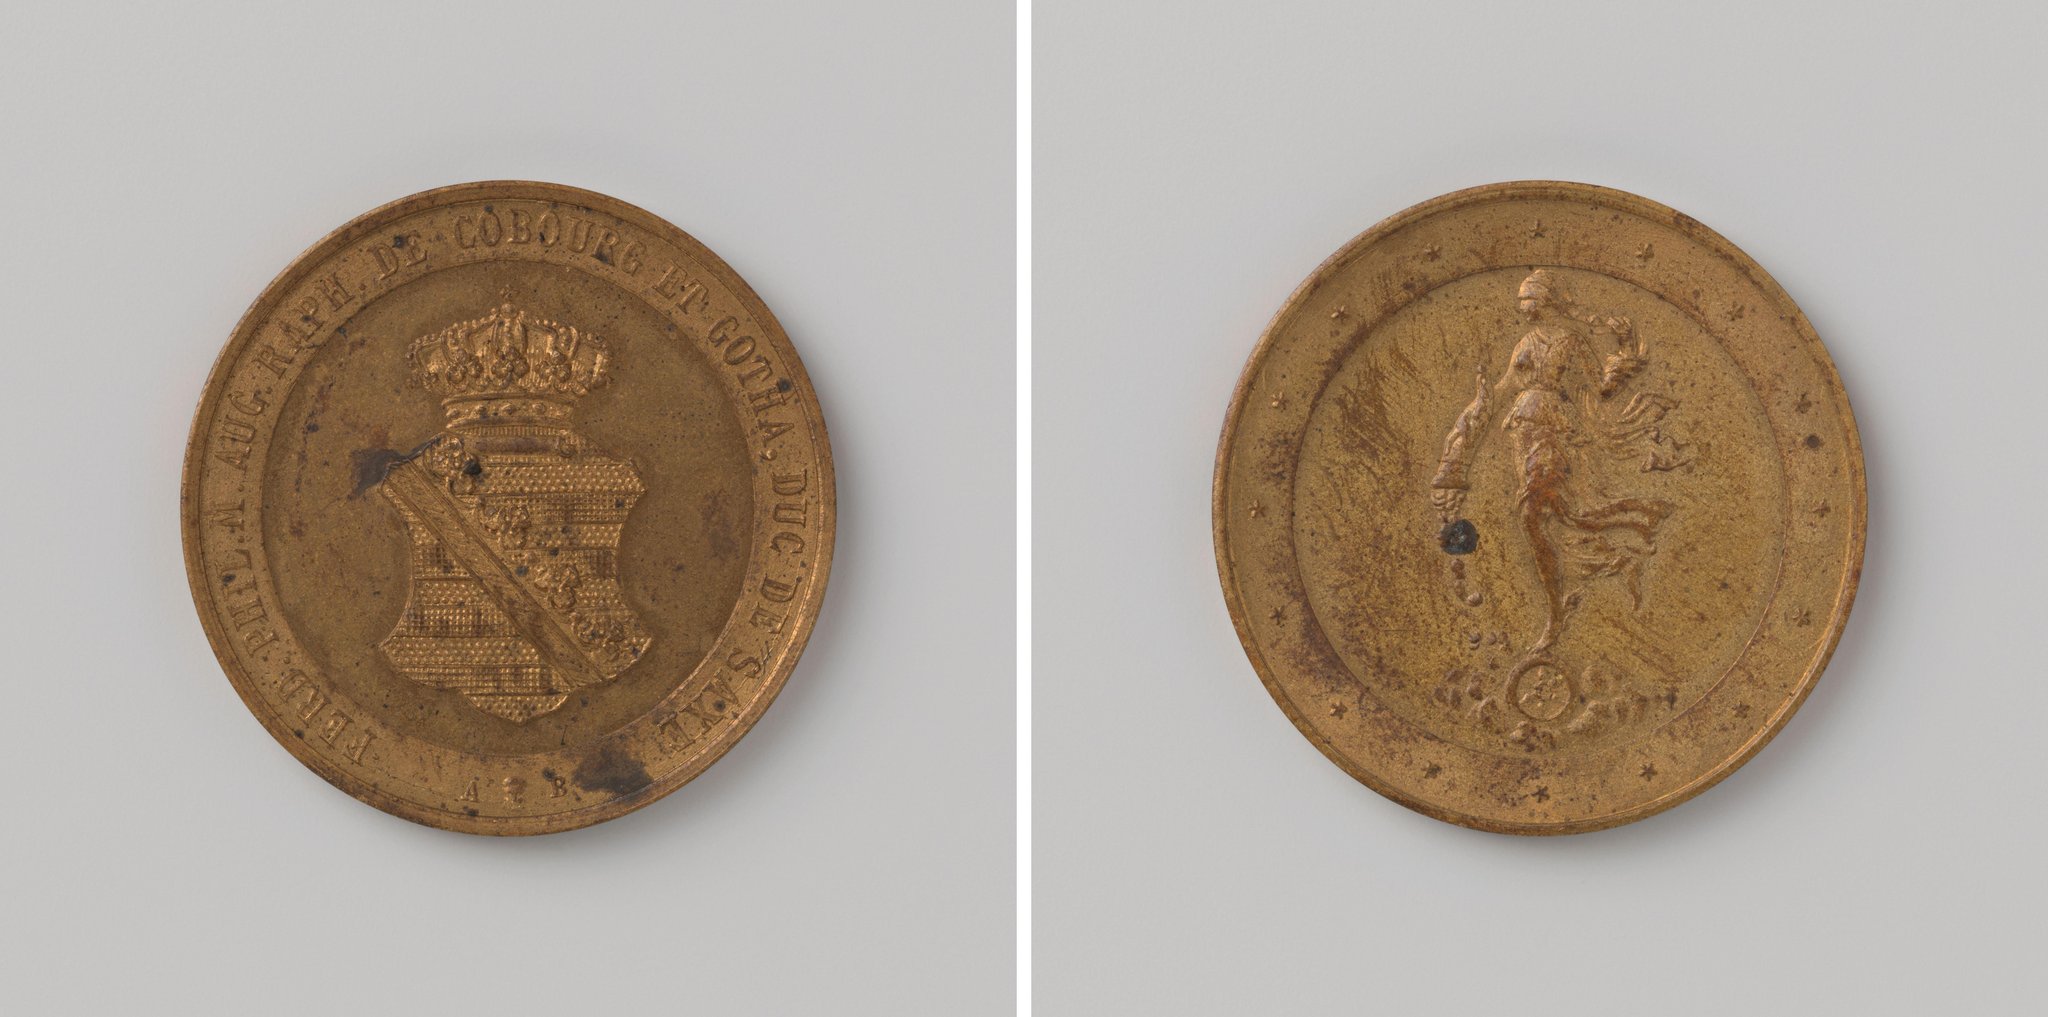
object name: history medal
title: Ferdinand Filips, hertog van Saksen-Coburg-Gotha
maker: auguste brichaut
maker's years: 1866-1890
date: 1878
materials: copper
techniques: striking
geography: brussels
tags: ferdinand filips m.a.r. hertog van saksen-coburg-gotha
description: Koperen penning. Voorzijde: gekroond wapenschild binnen omschrift. Keerzijde: vrouw met vleugeltjes aan haar voeten en omgekeerde hoorn van overvloed in hand, staande op wiel omgeven door wolken binnen rand van sterren